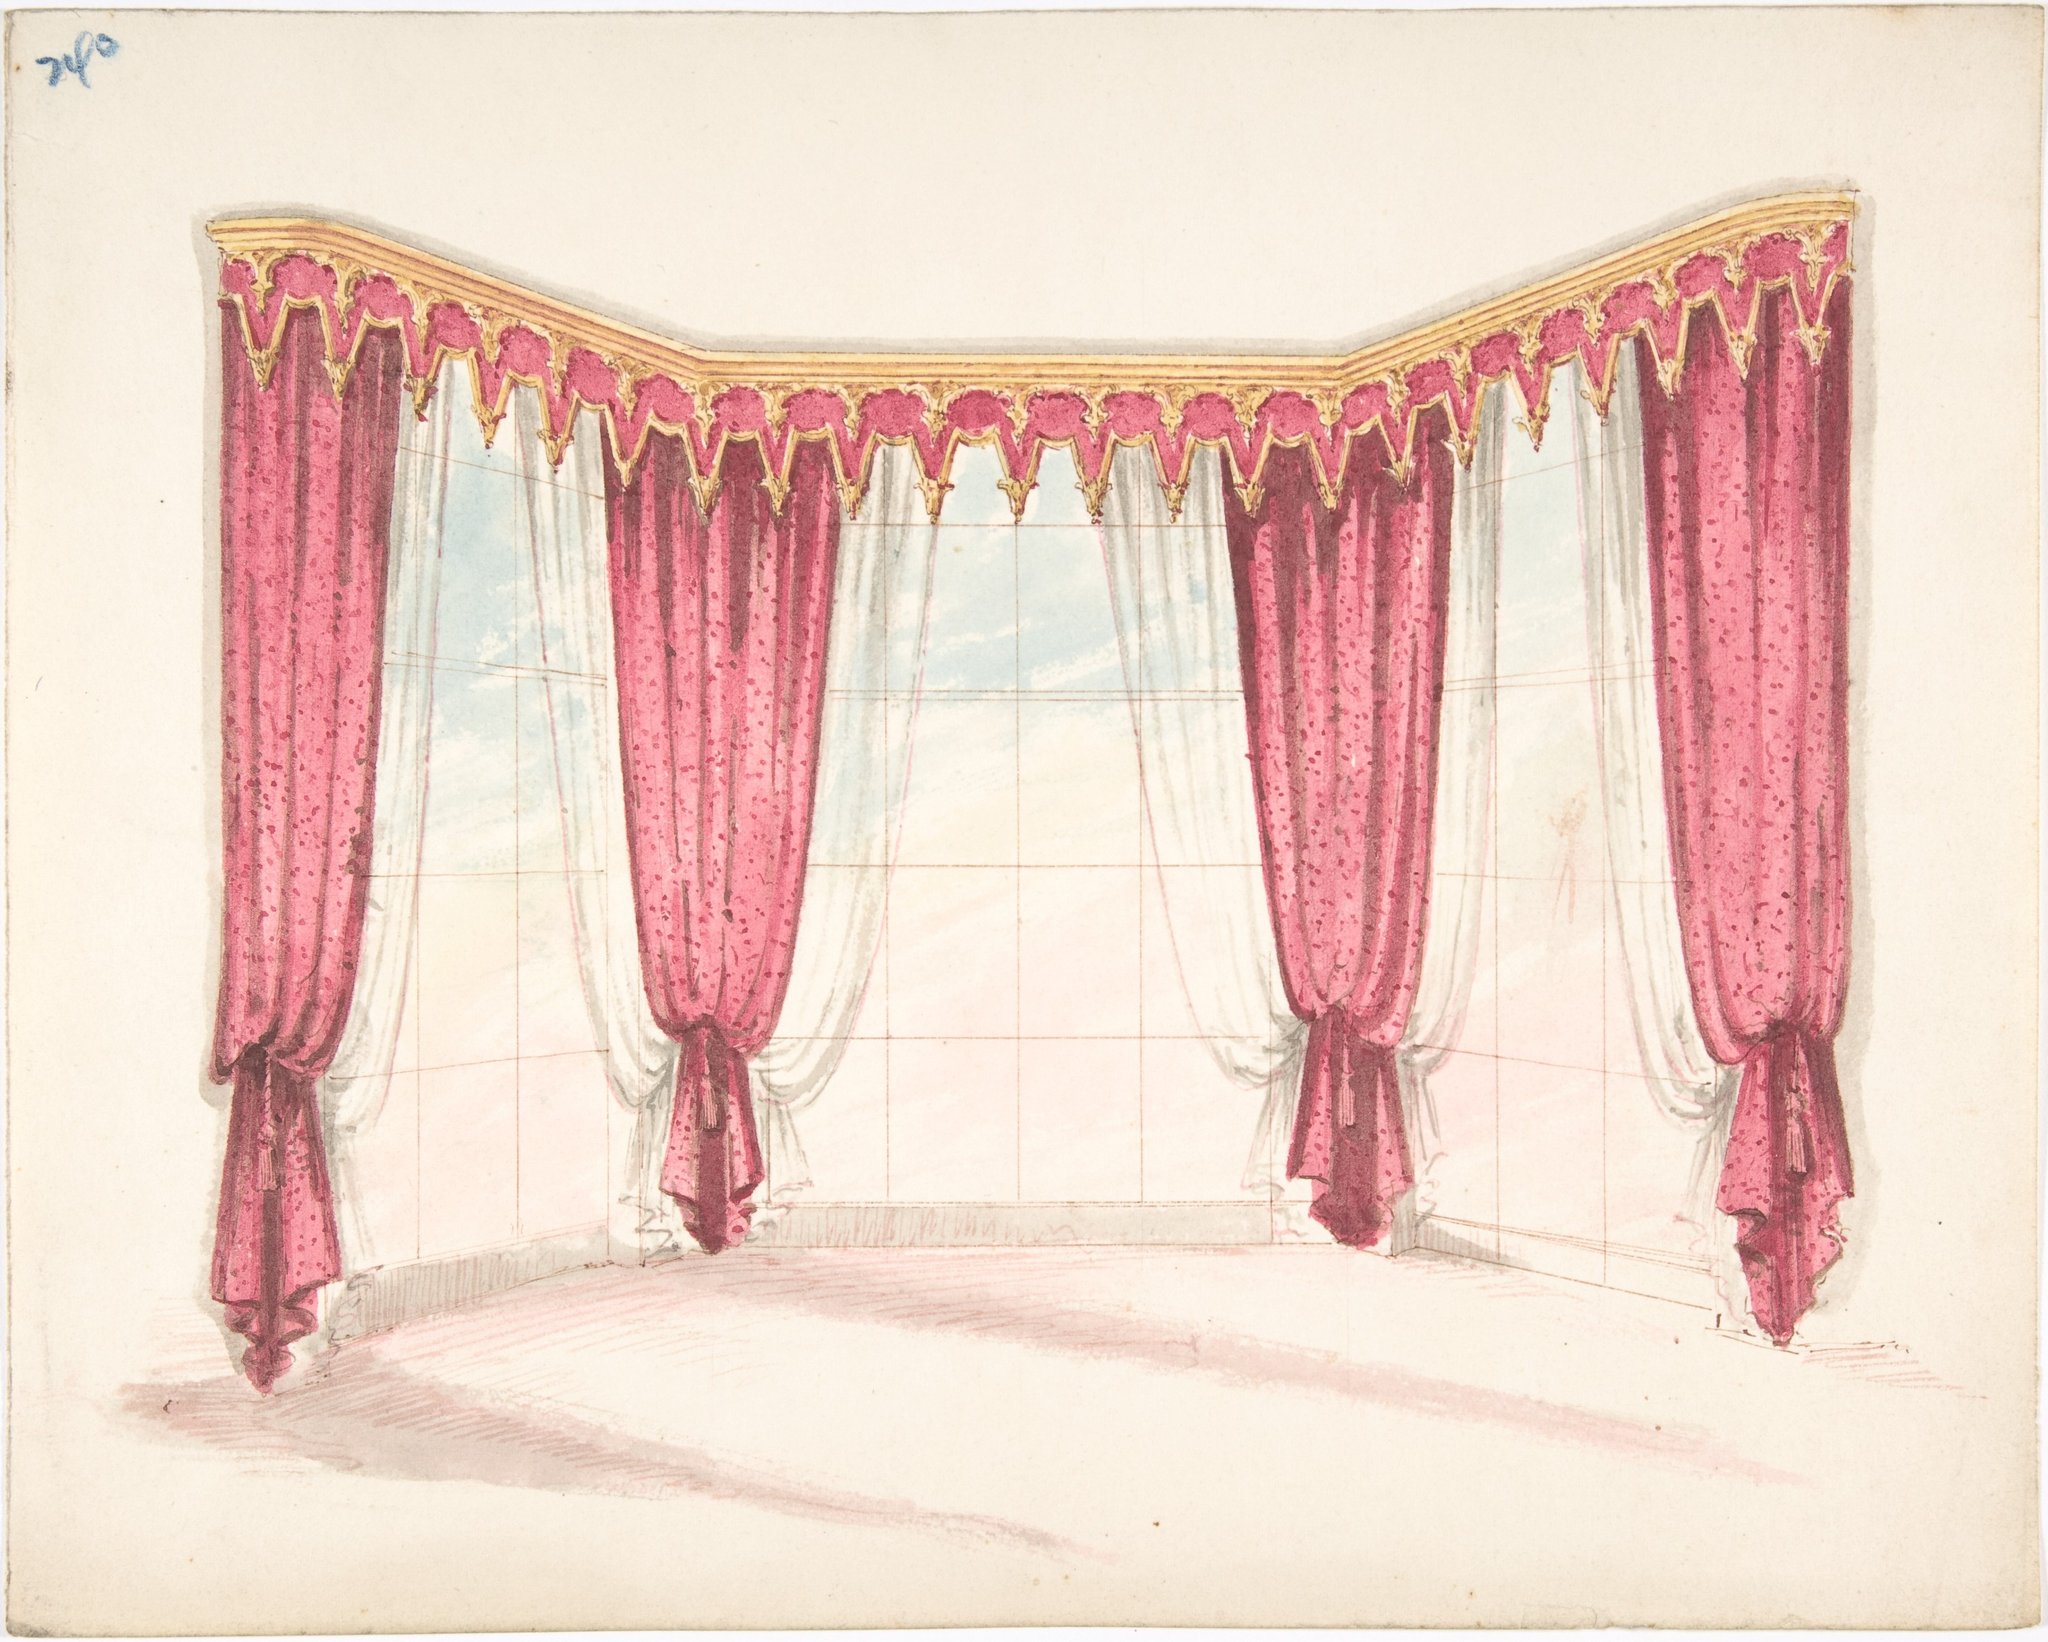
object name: drawing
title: Design for Red Curtains with a Red and Gold Pelmet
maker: anonymous, british, 19th century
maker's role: artist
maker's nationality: british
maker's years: 1800-1900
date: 1801-1833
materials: ink, watercolor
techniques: brush, pen, wash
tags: windows,curtains